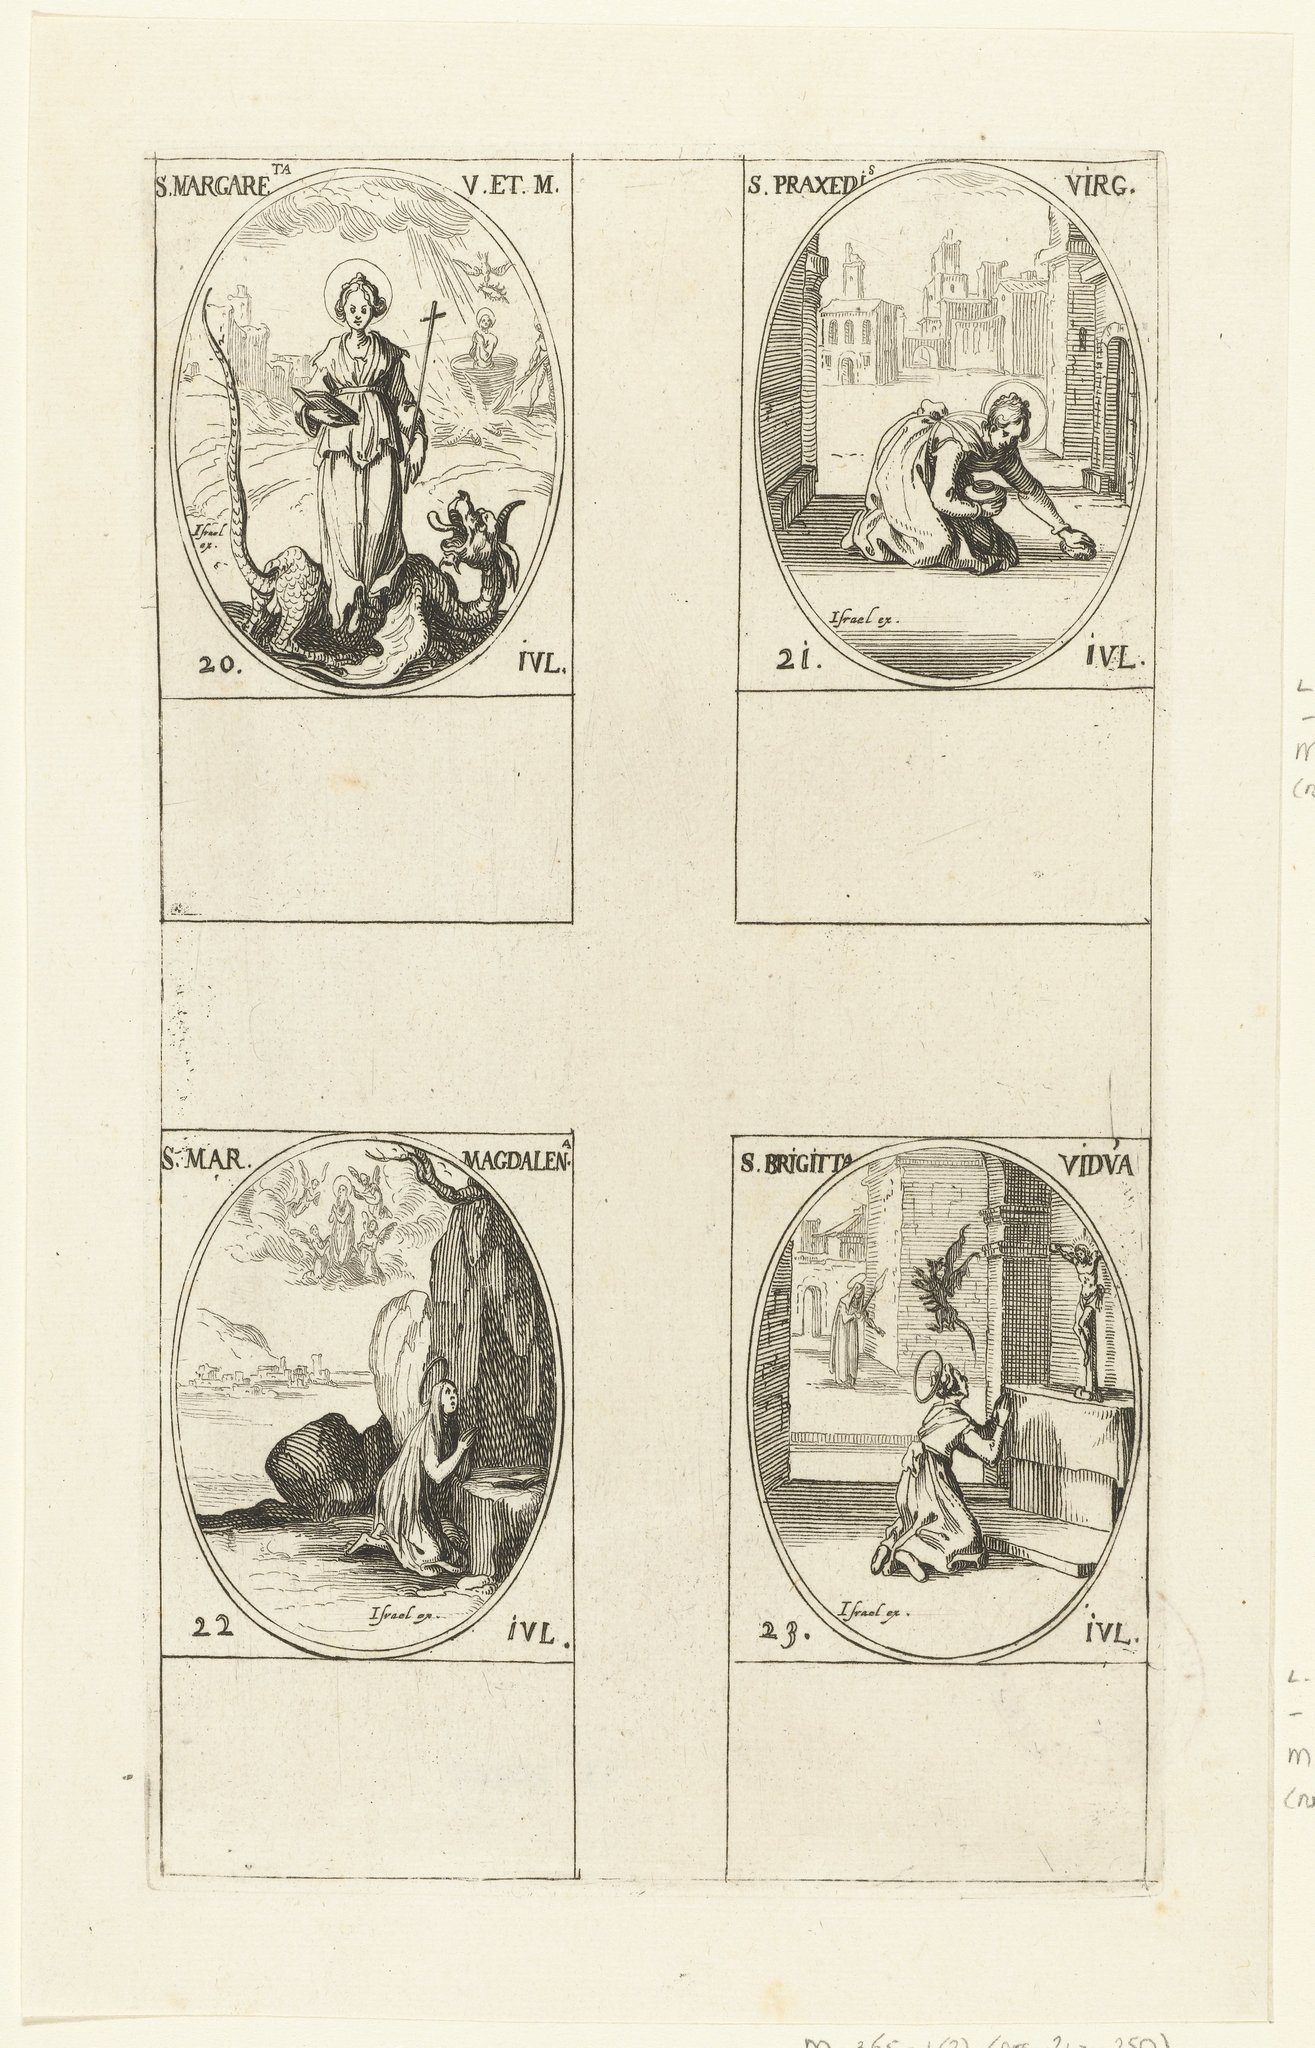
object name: print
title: Alle heiligen en de Christelijke feestdagen van het jaar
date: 1632-1636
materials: paper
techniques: etching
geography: paris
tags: the penitent st. mary magdalene (often before a cave, possibly at la sainte-baume hill): her long hair covers her (naked) body, she reads, meditates or raises her tear-filled eyes towards heaven, the foundress of the order of bri(d)gettines, the widow bridget (birgitta) of sweden; possible attributes: band over veil with five red spots, book, candle, heart with cross, inkhorn, pilgrim's hat, staff, wallet, female saints (with name), st. margaret is plunged in boiling water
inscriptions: collector's mark: Lugt 240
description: Blad met vier ovale voorstellingen, elk met opschrift en datum in het Latijn: linksboven de Heilige Margaretha staand op een draak, rechtsboven de Heilige Praxedes die een vloer boent, linksonder de Heilige Maria Magdalena als kluizenares in de wildernis, rechtsonder de Heilige Birgitta van Zweden biddend bij een crucifix. Deze prent is onderdeel van een serie prenten met voorstellingen van de heiligen en de christelijke feestdagen van het jaar. Er zijn steeds vier scènes van één plaat op één blad gedrukt. Inclusief bijbehorend titelblad en frontispice gaat het in totaal om 124 platen (490 voorstellingen). De drie platen met de laatste 12 scènes (de veranderlijke christelijke feestdagen) zijn in de derde staat versneden tot 12 kleine plaatjes, en met een apart titelblad uitgegeven.